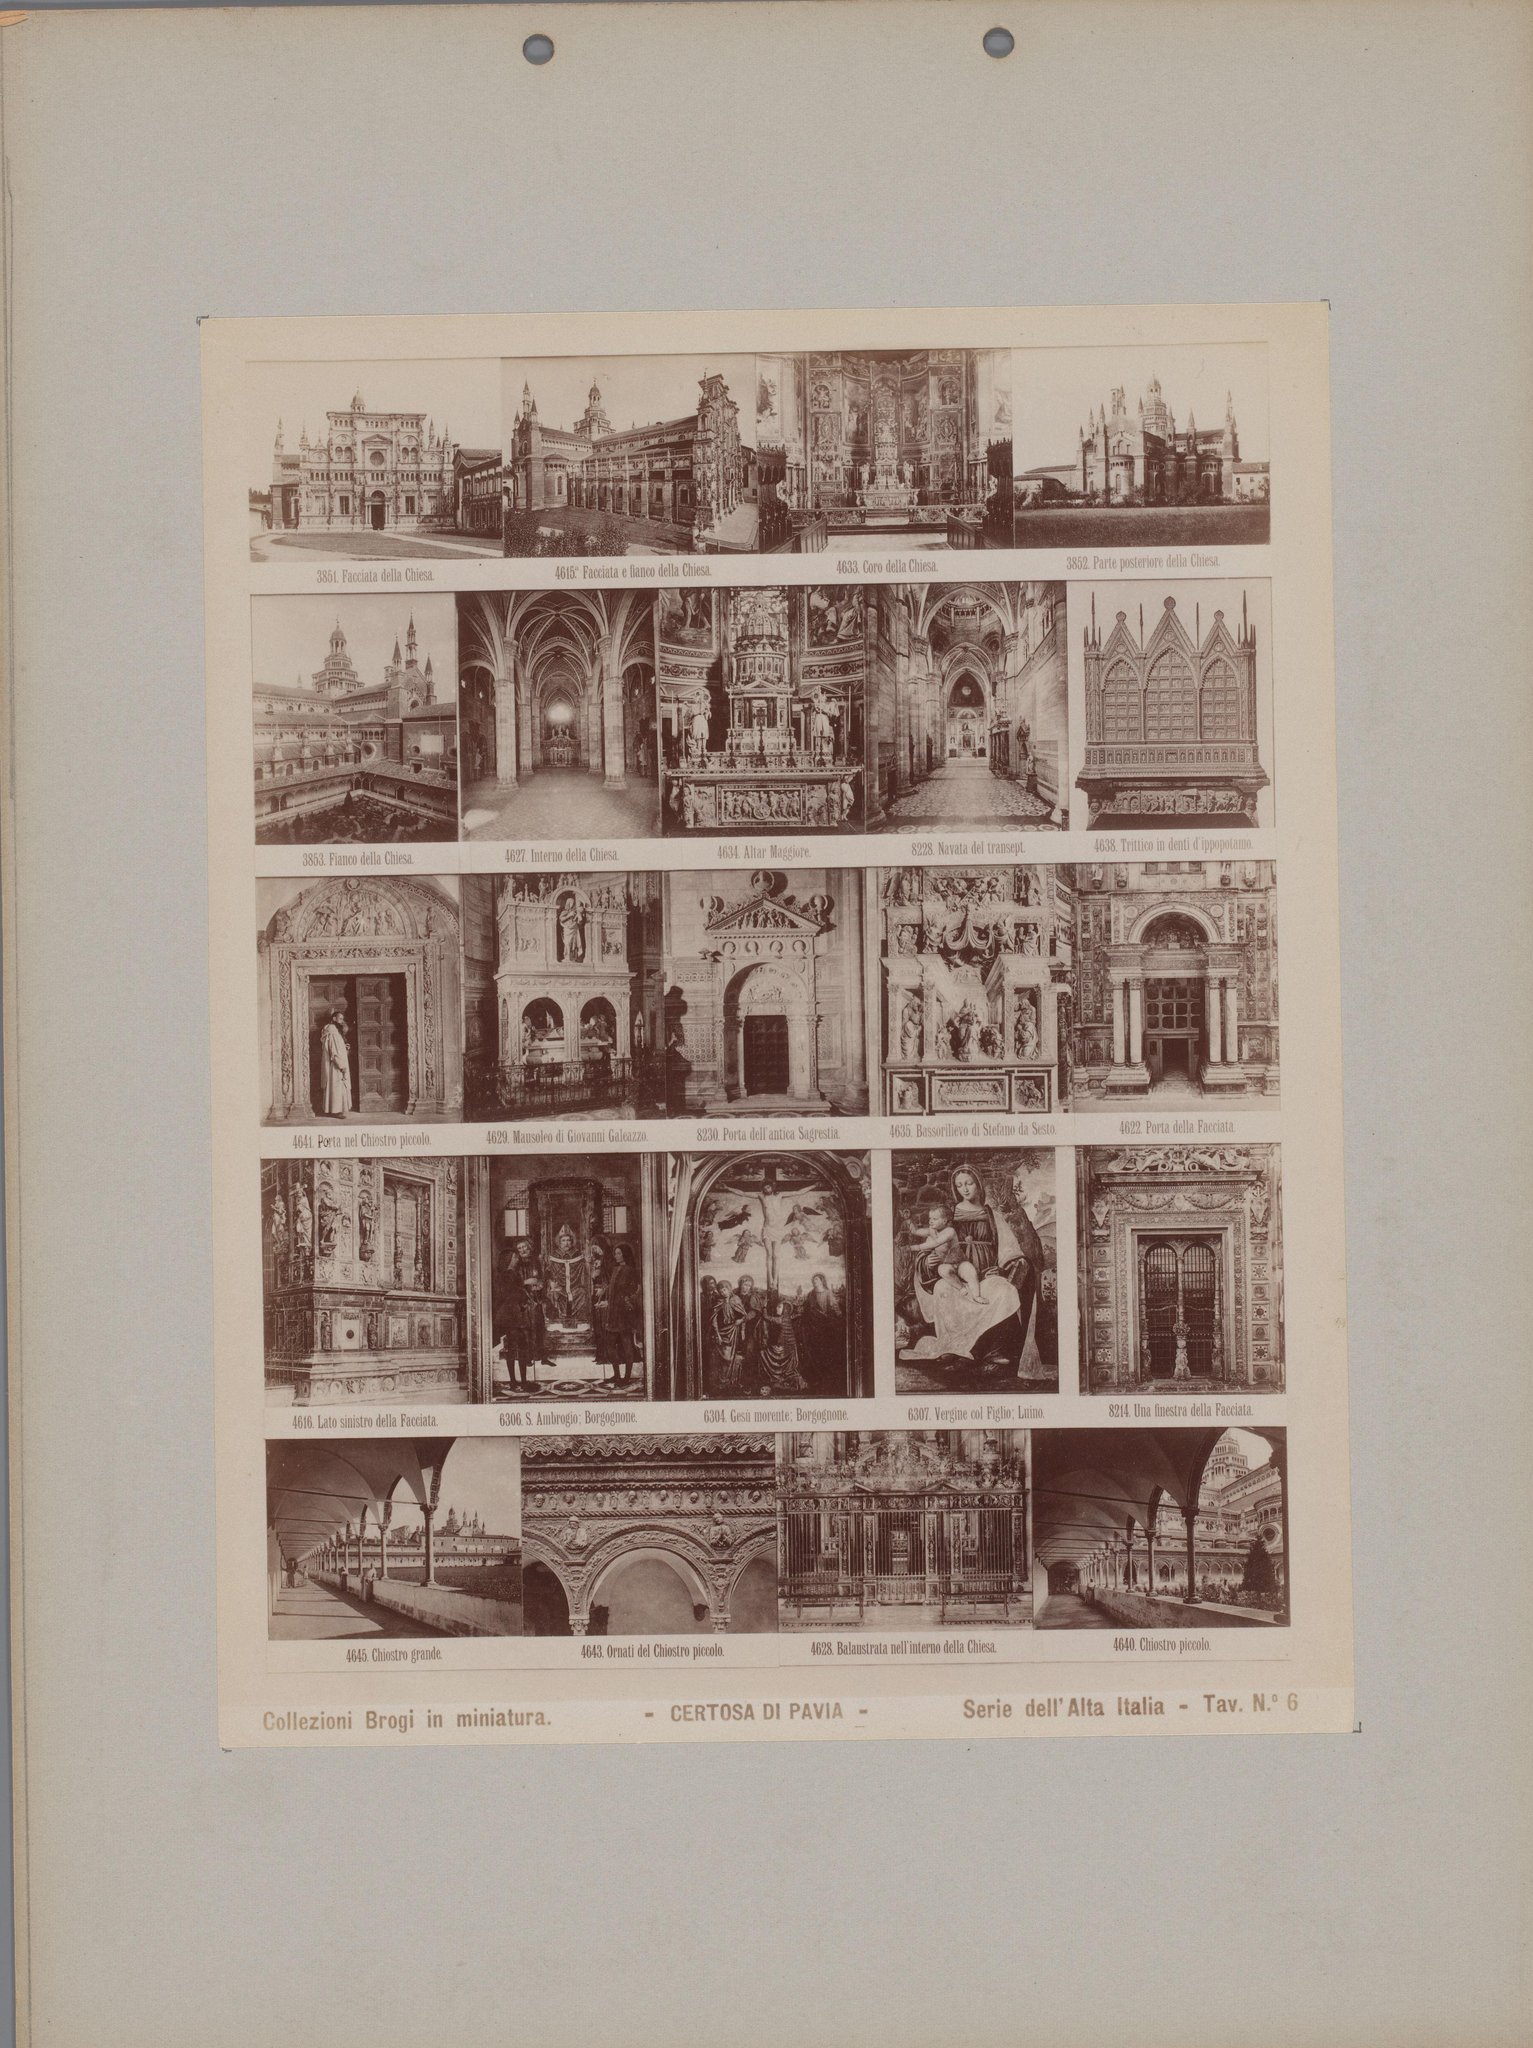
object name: photograph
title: Collezioni Brogi in miniatura, serie dell' Alta Italia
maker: giacomo brogi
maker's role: fotograaf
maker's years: 1822-1881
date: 1856-1881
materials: cardboard, paper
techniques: albumen print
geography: certosa di pavia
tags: abbey, monastery, convent ~ roman catholic church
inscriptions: number: ‘Tav. No. 6’